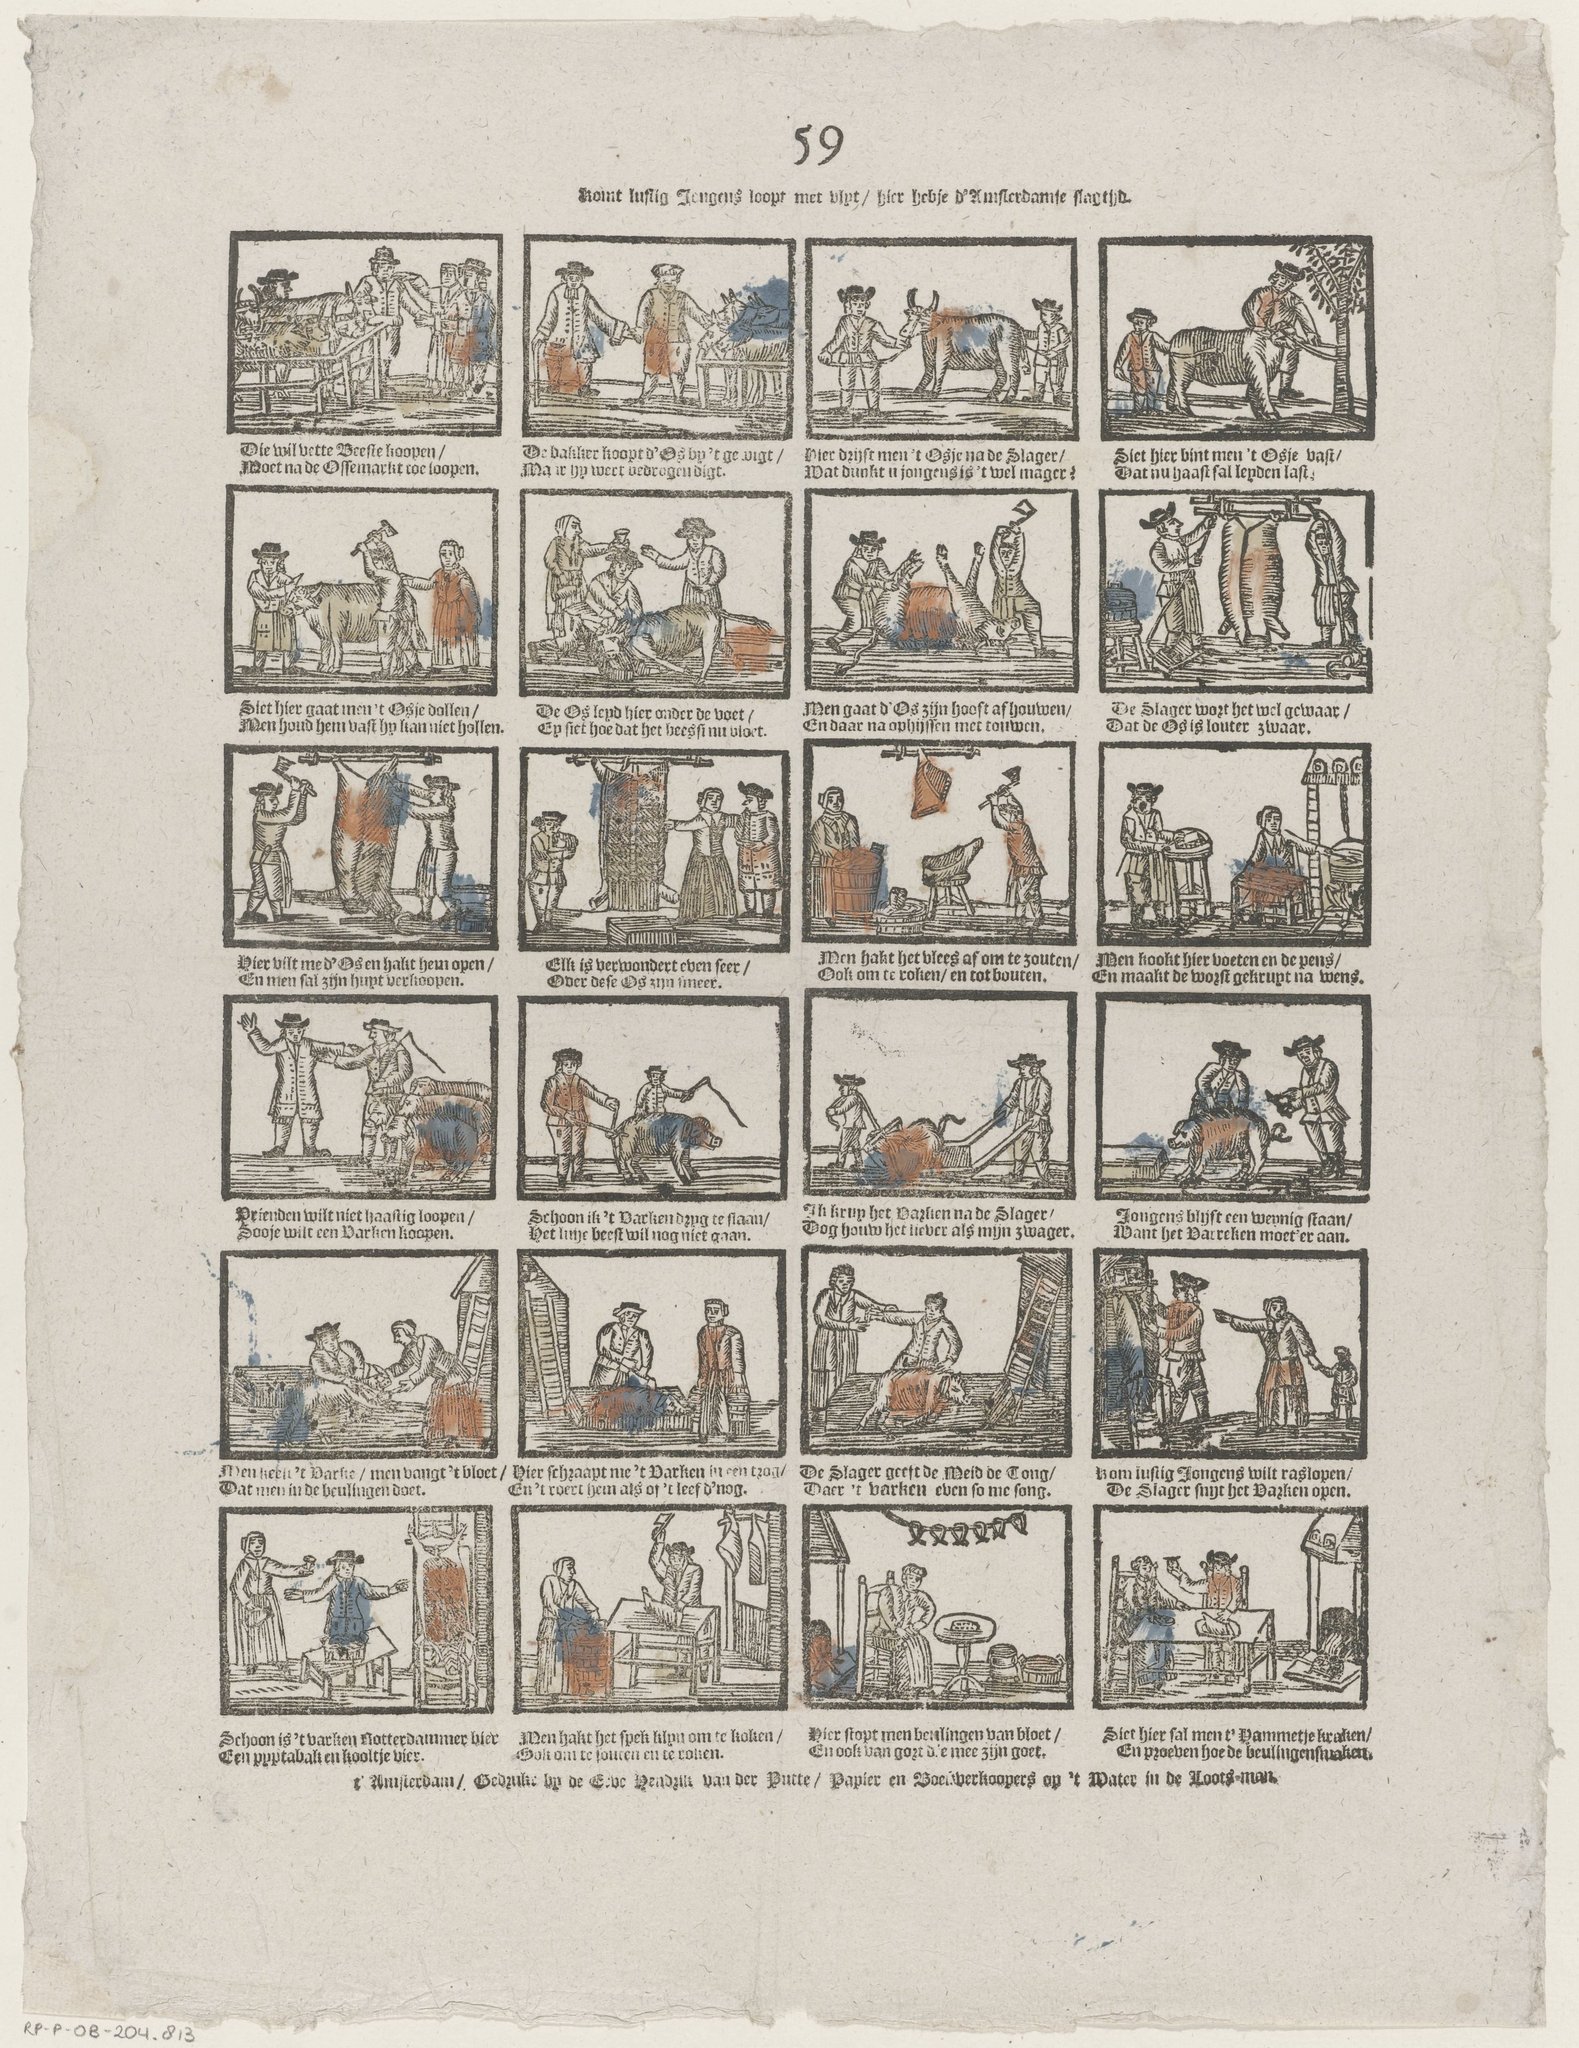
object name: print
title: Komt lustig jongens loopt met vlyt / hier hebje d'Amsterdamse slagtijd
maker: Anonymous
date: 1767-1793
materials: paper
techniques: colour, letterpress printing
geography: amsterdam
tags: slaughtered ox or pig, butcher, slaughterman, amsterdam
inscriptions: collector's mark: Lugt 2760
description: Blad met 24 voorstellingen van het fokken, slachten en bereiden van koeien en varkens. Onder elke afbeelding een tweeregelig vers. Genummerd midden boven: 59.